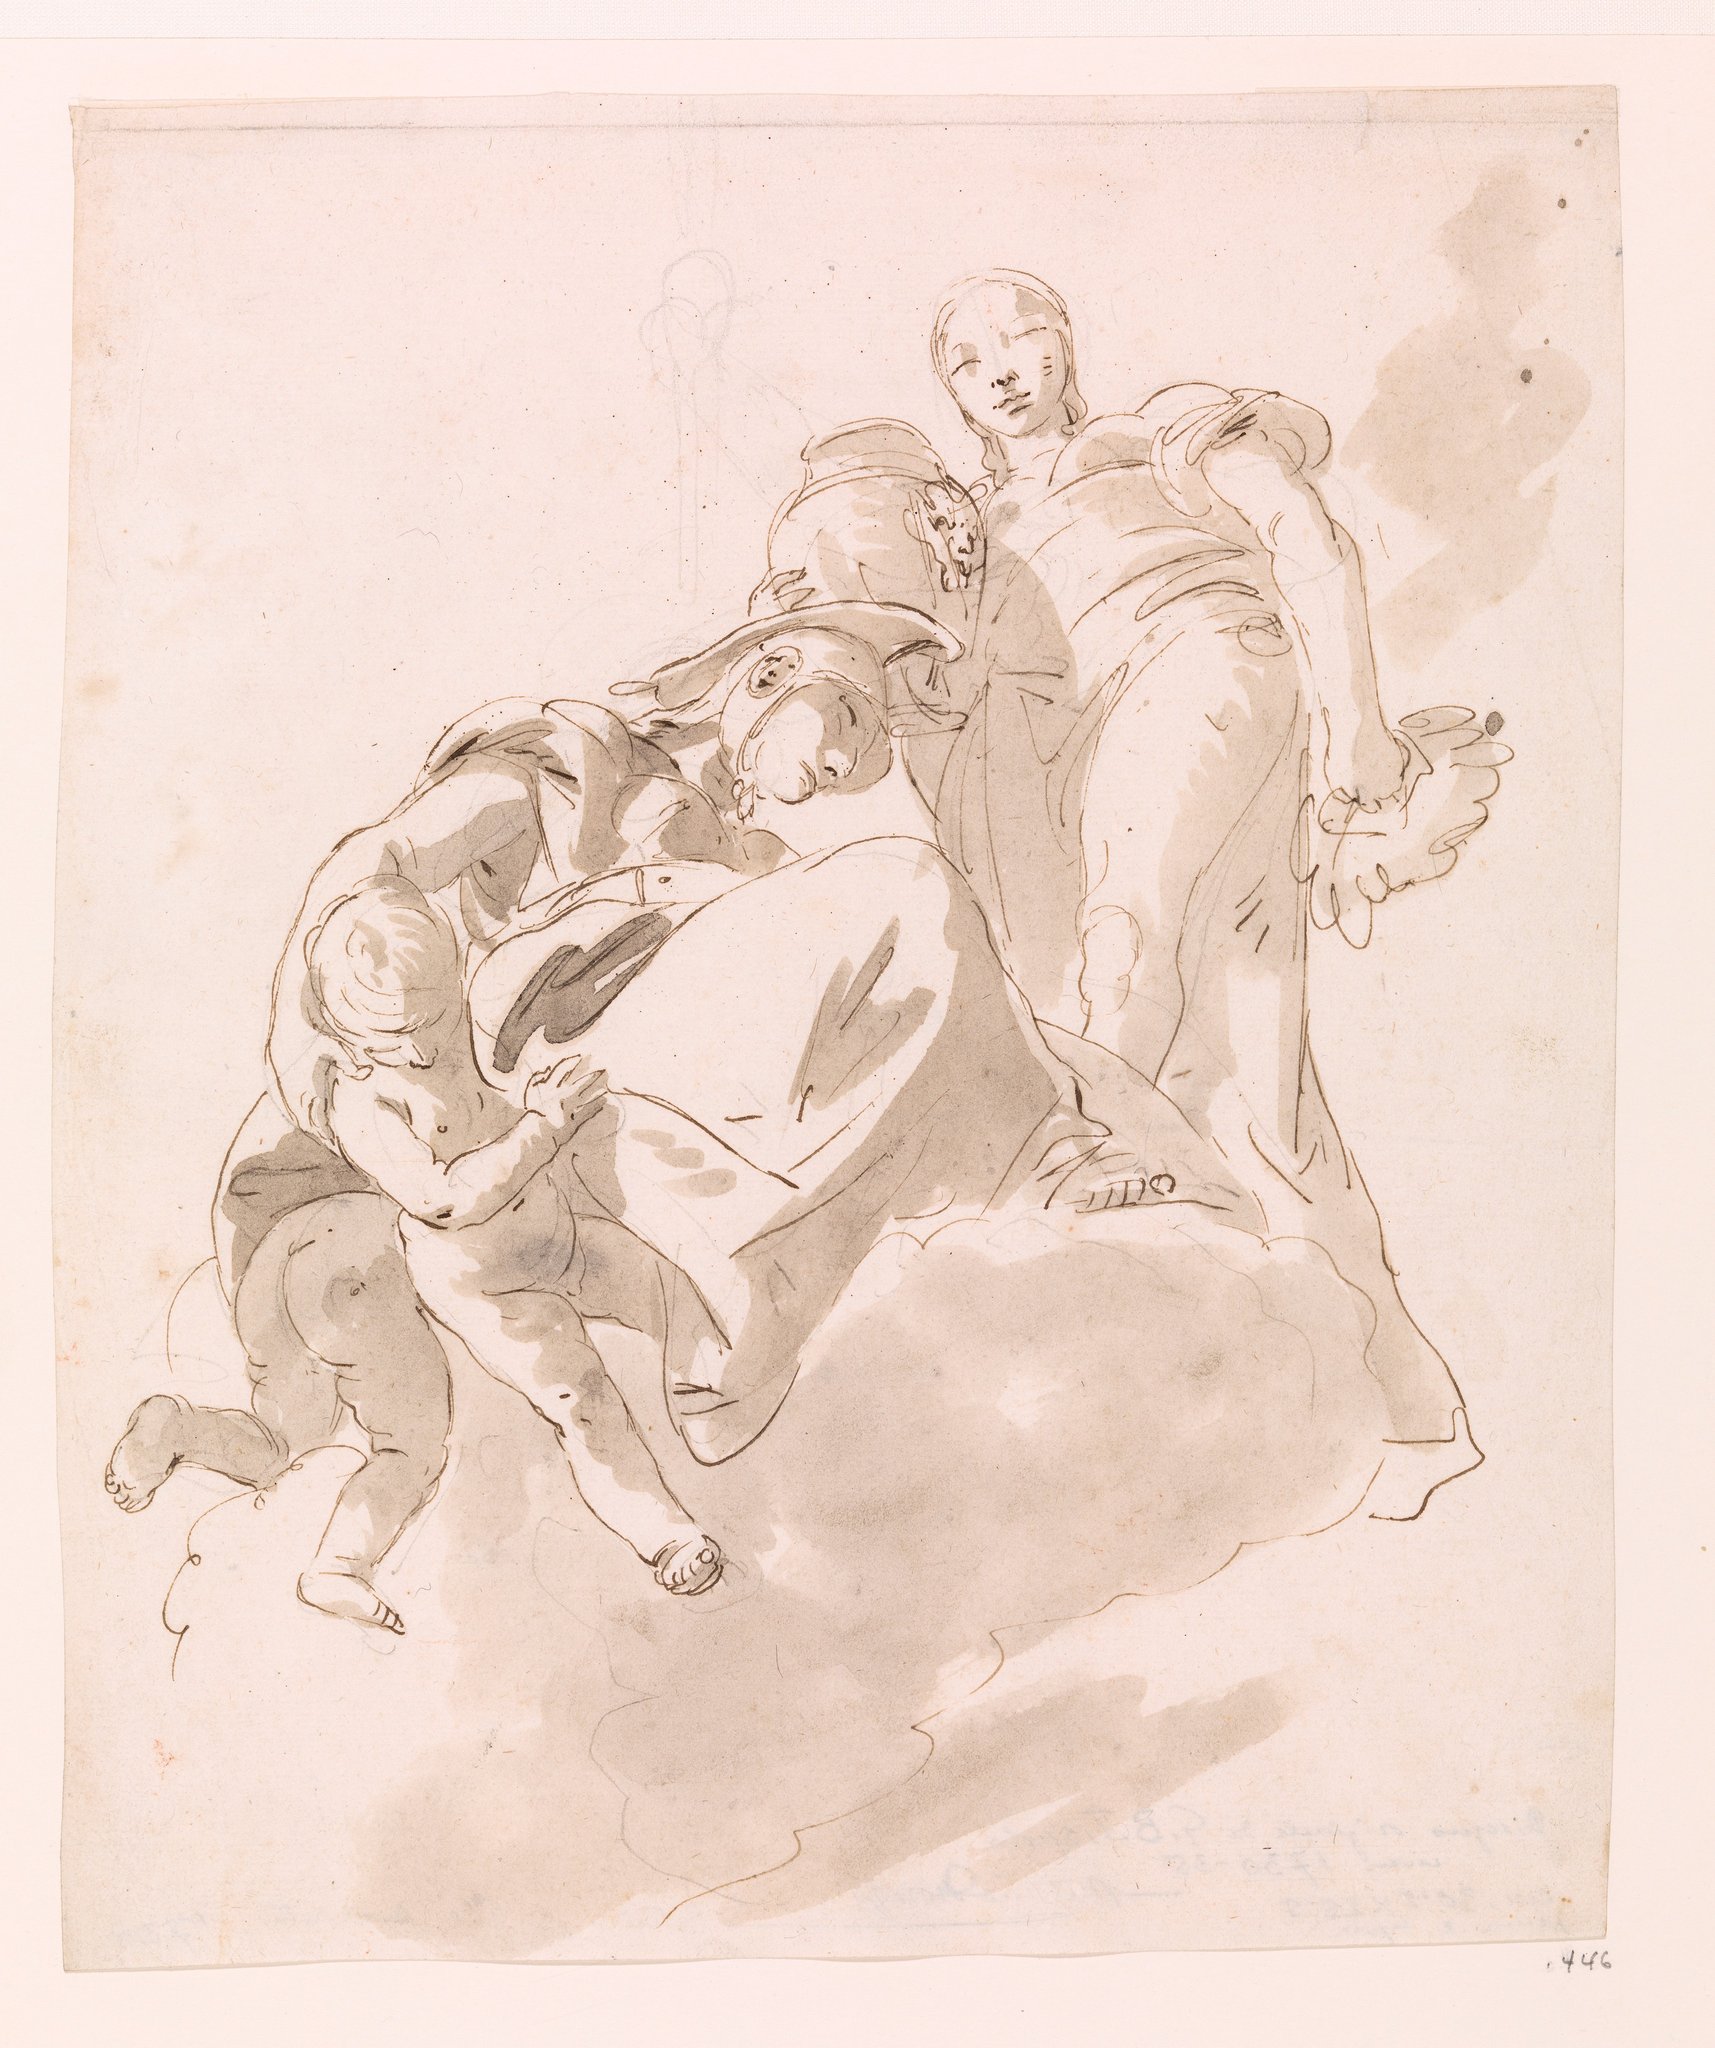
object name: drawing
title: Two Allegorical Figures for a Ceiling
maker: giovanni battista tiepolo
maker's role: artist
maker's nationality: italian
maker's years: 1696-1770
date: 1734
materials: chalk, ink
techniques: pen, wash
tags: children,men,women